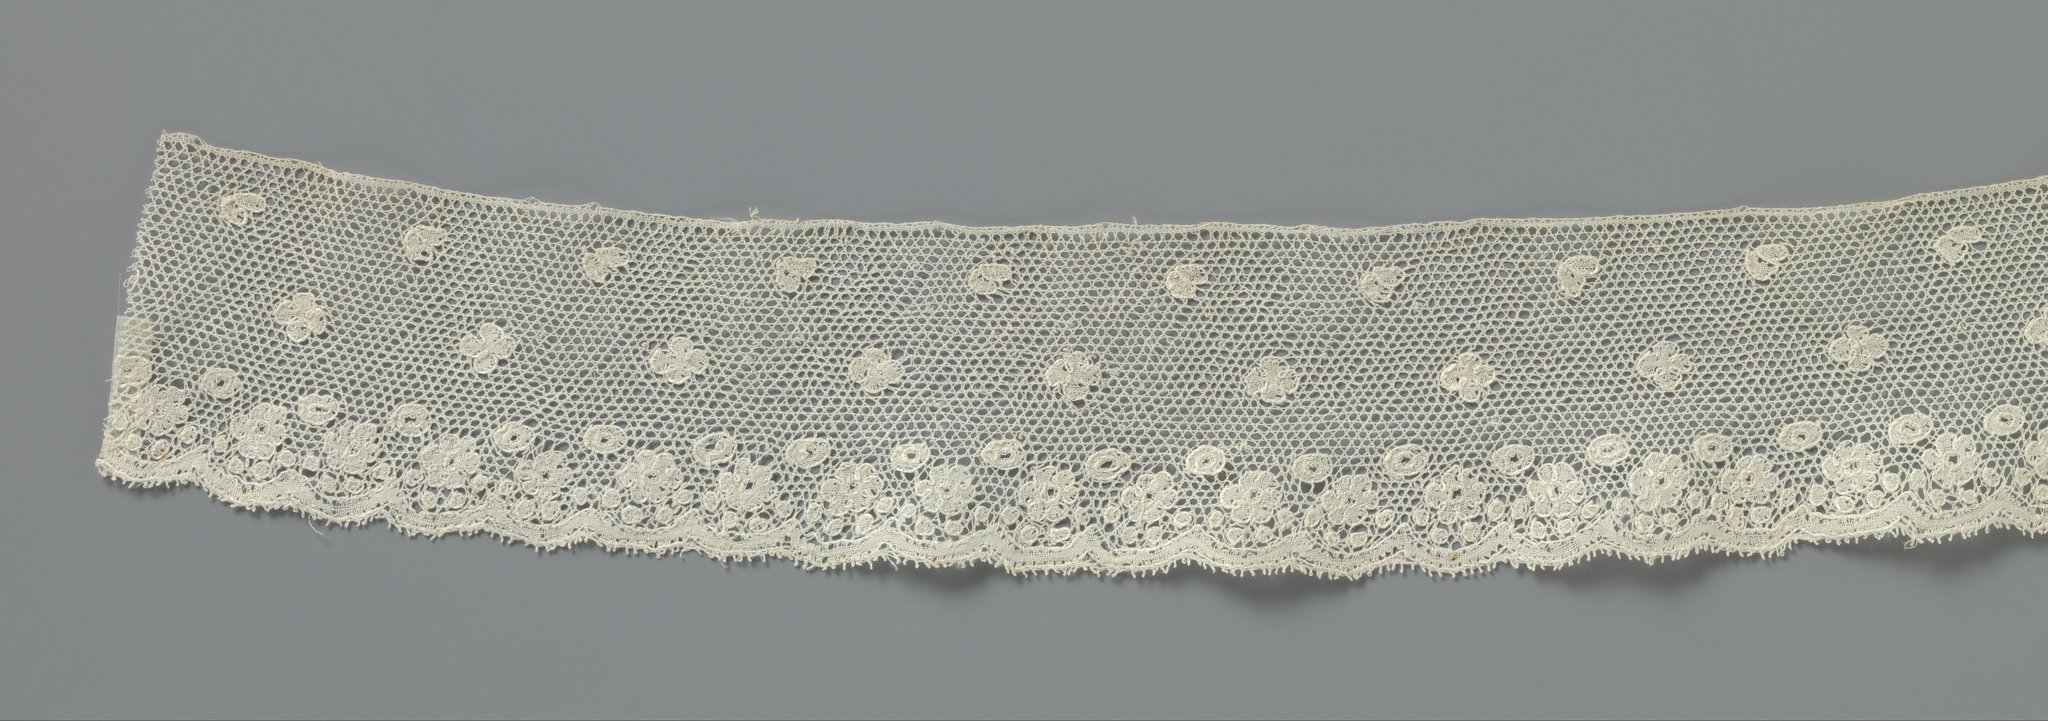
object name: strip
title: Strook kloskant met klavertjes vier en rozetrand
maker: Anonymous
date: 1800-1824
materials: linen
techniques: lace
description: Strook naturelkleurige kloskant, Parijse kant. De bovenste helft van de strook bestaat uit een rij dubbele blaadjes en een rij klavertjes vier. Het zich herhalende patroon langs de onderzijde van de strook bestaat uit een rij opengewerkte cirkels, met dicht daaronder een rij rozetbloemen. Elke rozetbloem ligt in een schulp, waarin vier losse moesjes liggen. Langs de schulpen loopt een bandje. De motieven zijn met elkaar verbonden door een maasgrond, een Parijse grond. De motieven zijn gemaakt in linnenslag met dikkere en glimmende contourdraden. De bovenzijde van de strook is recht afgewerkt. De schulpen aan de onderzijde zijn afgewerkt met picots.